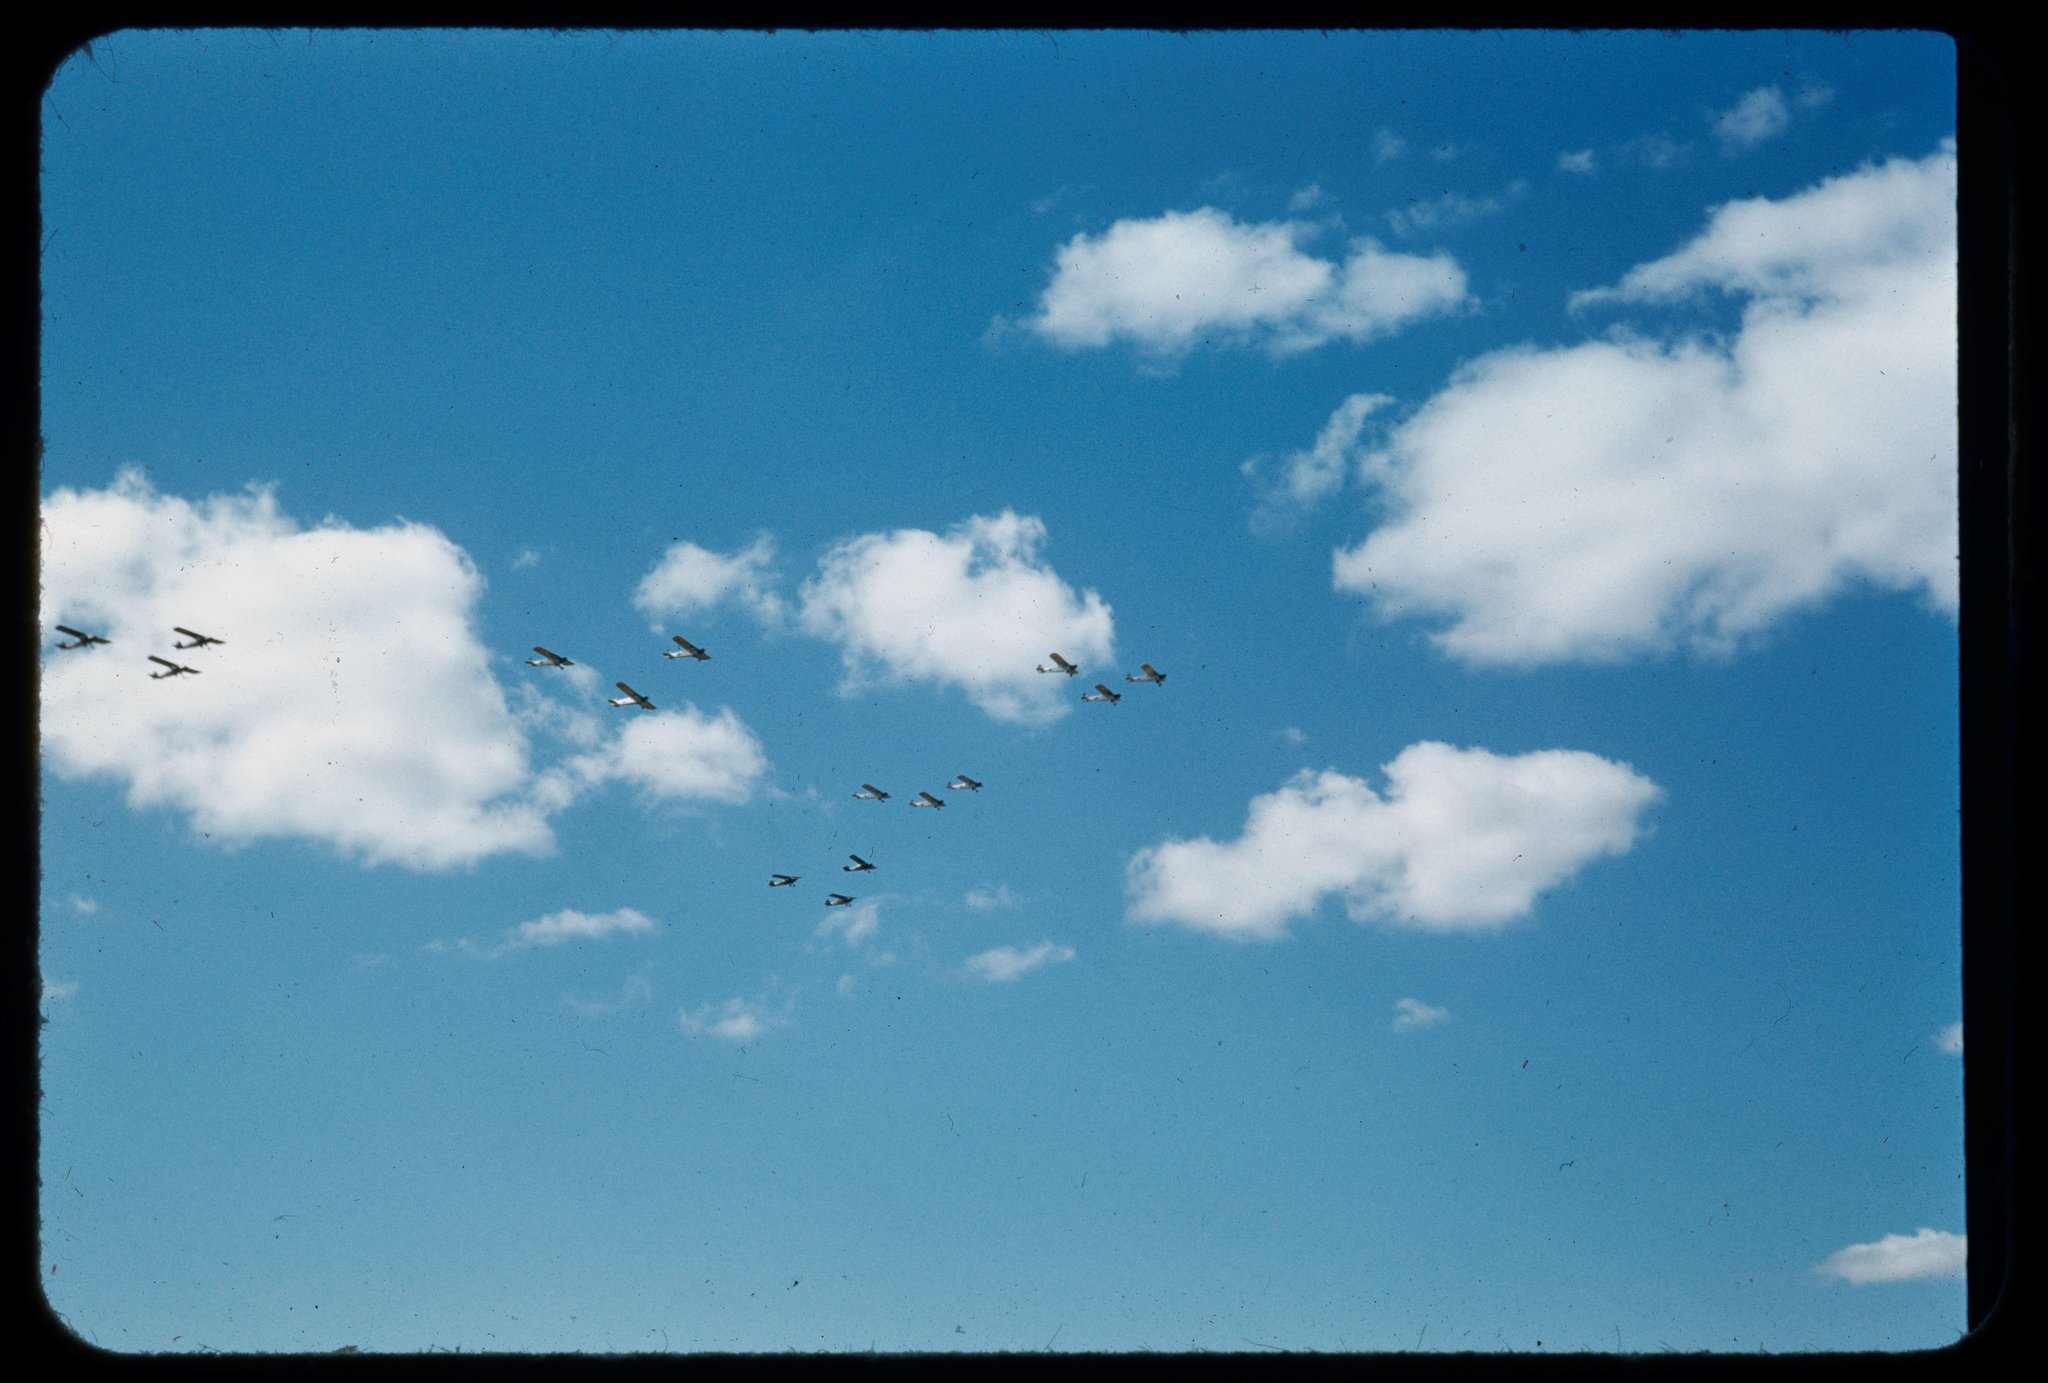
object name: color slide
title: Oorlog in Korea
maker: david ketel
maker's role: diplomaat, sinoloog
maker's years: 1913-2008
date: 1909-1952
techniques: slide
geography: korea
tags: united nations